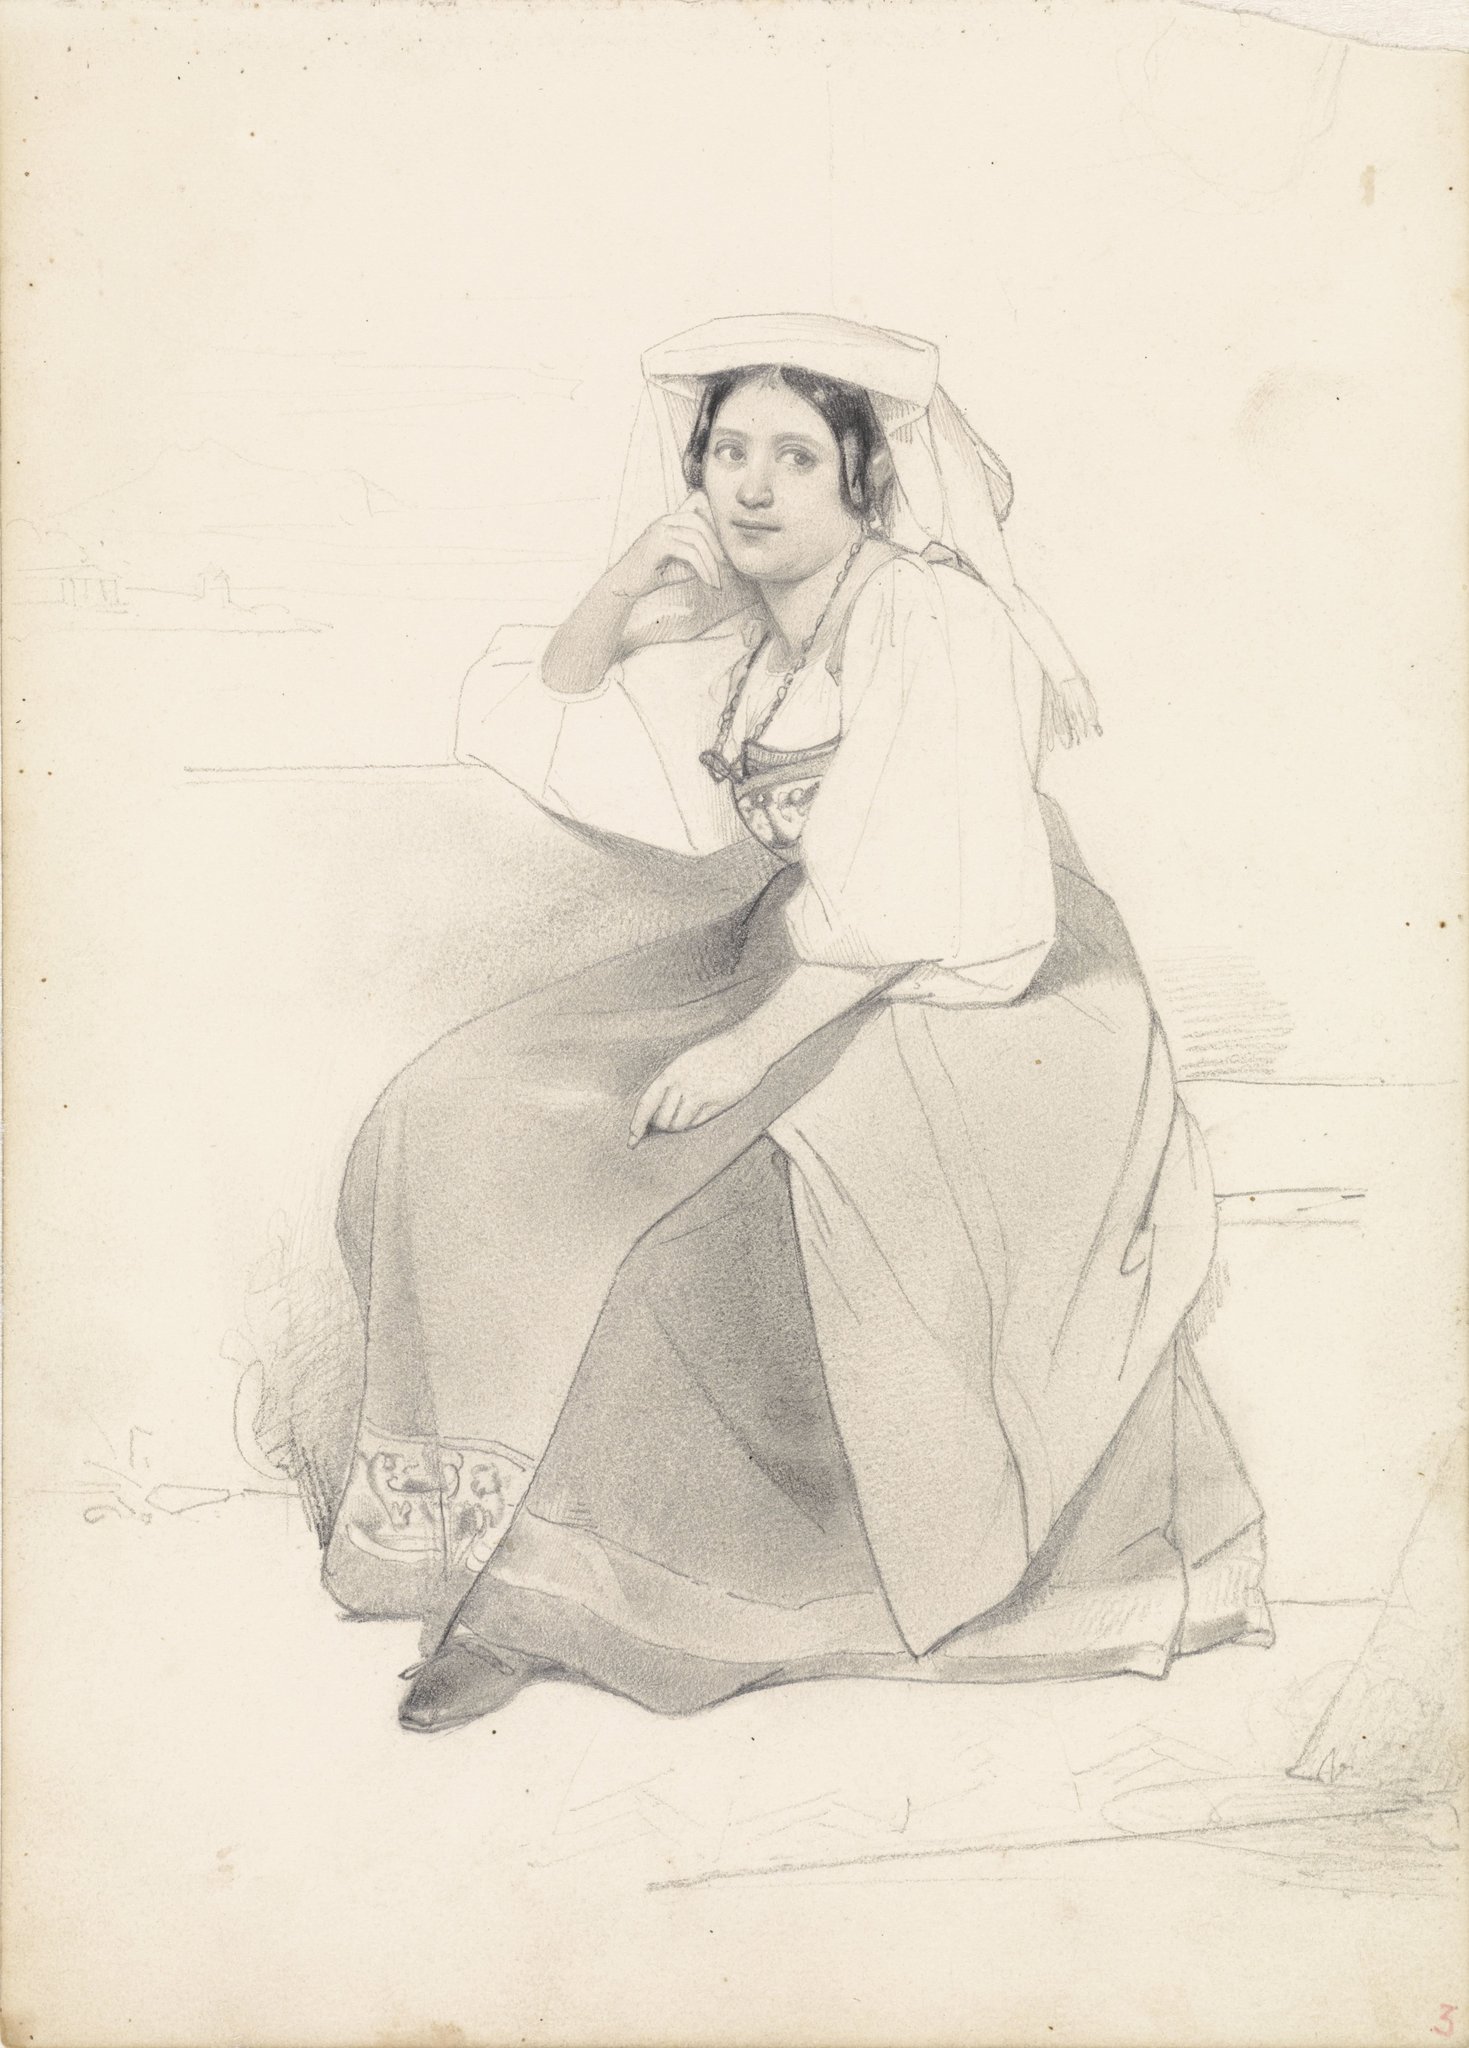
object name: drawing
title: Zittende vrouw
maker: johan hendrik koelman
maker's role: draughtsman, print maker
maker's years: 1820-1887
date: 1830-1887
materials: paper, pencil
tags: folk costume, regional costume, italy